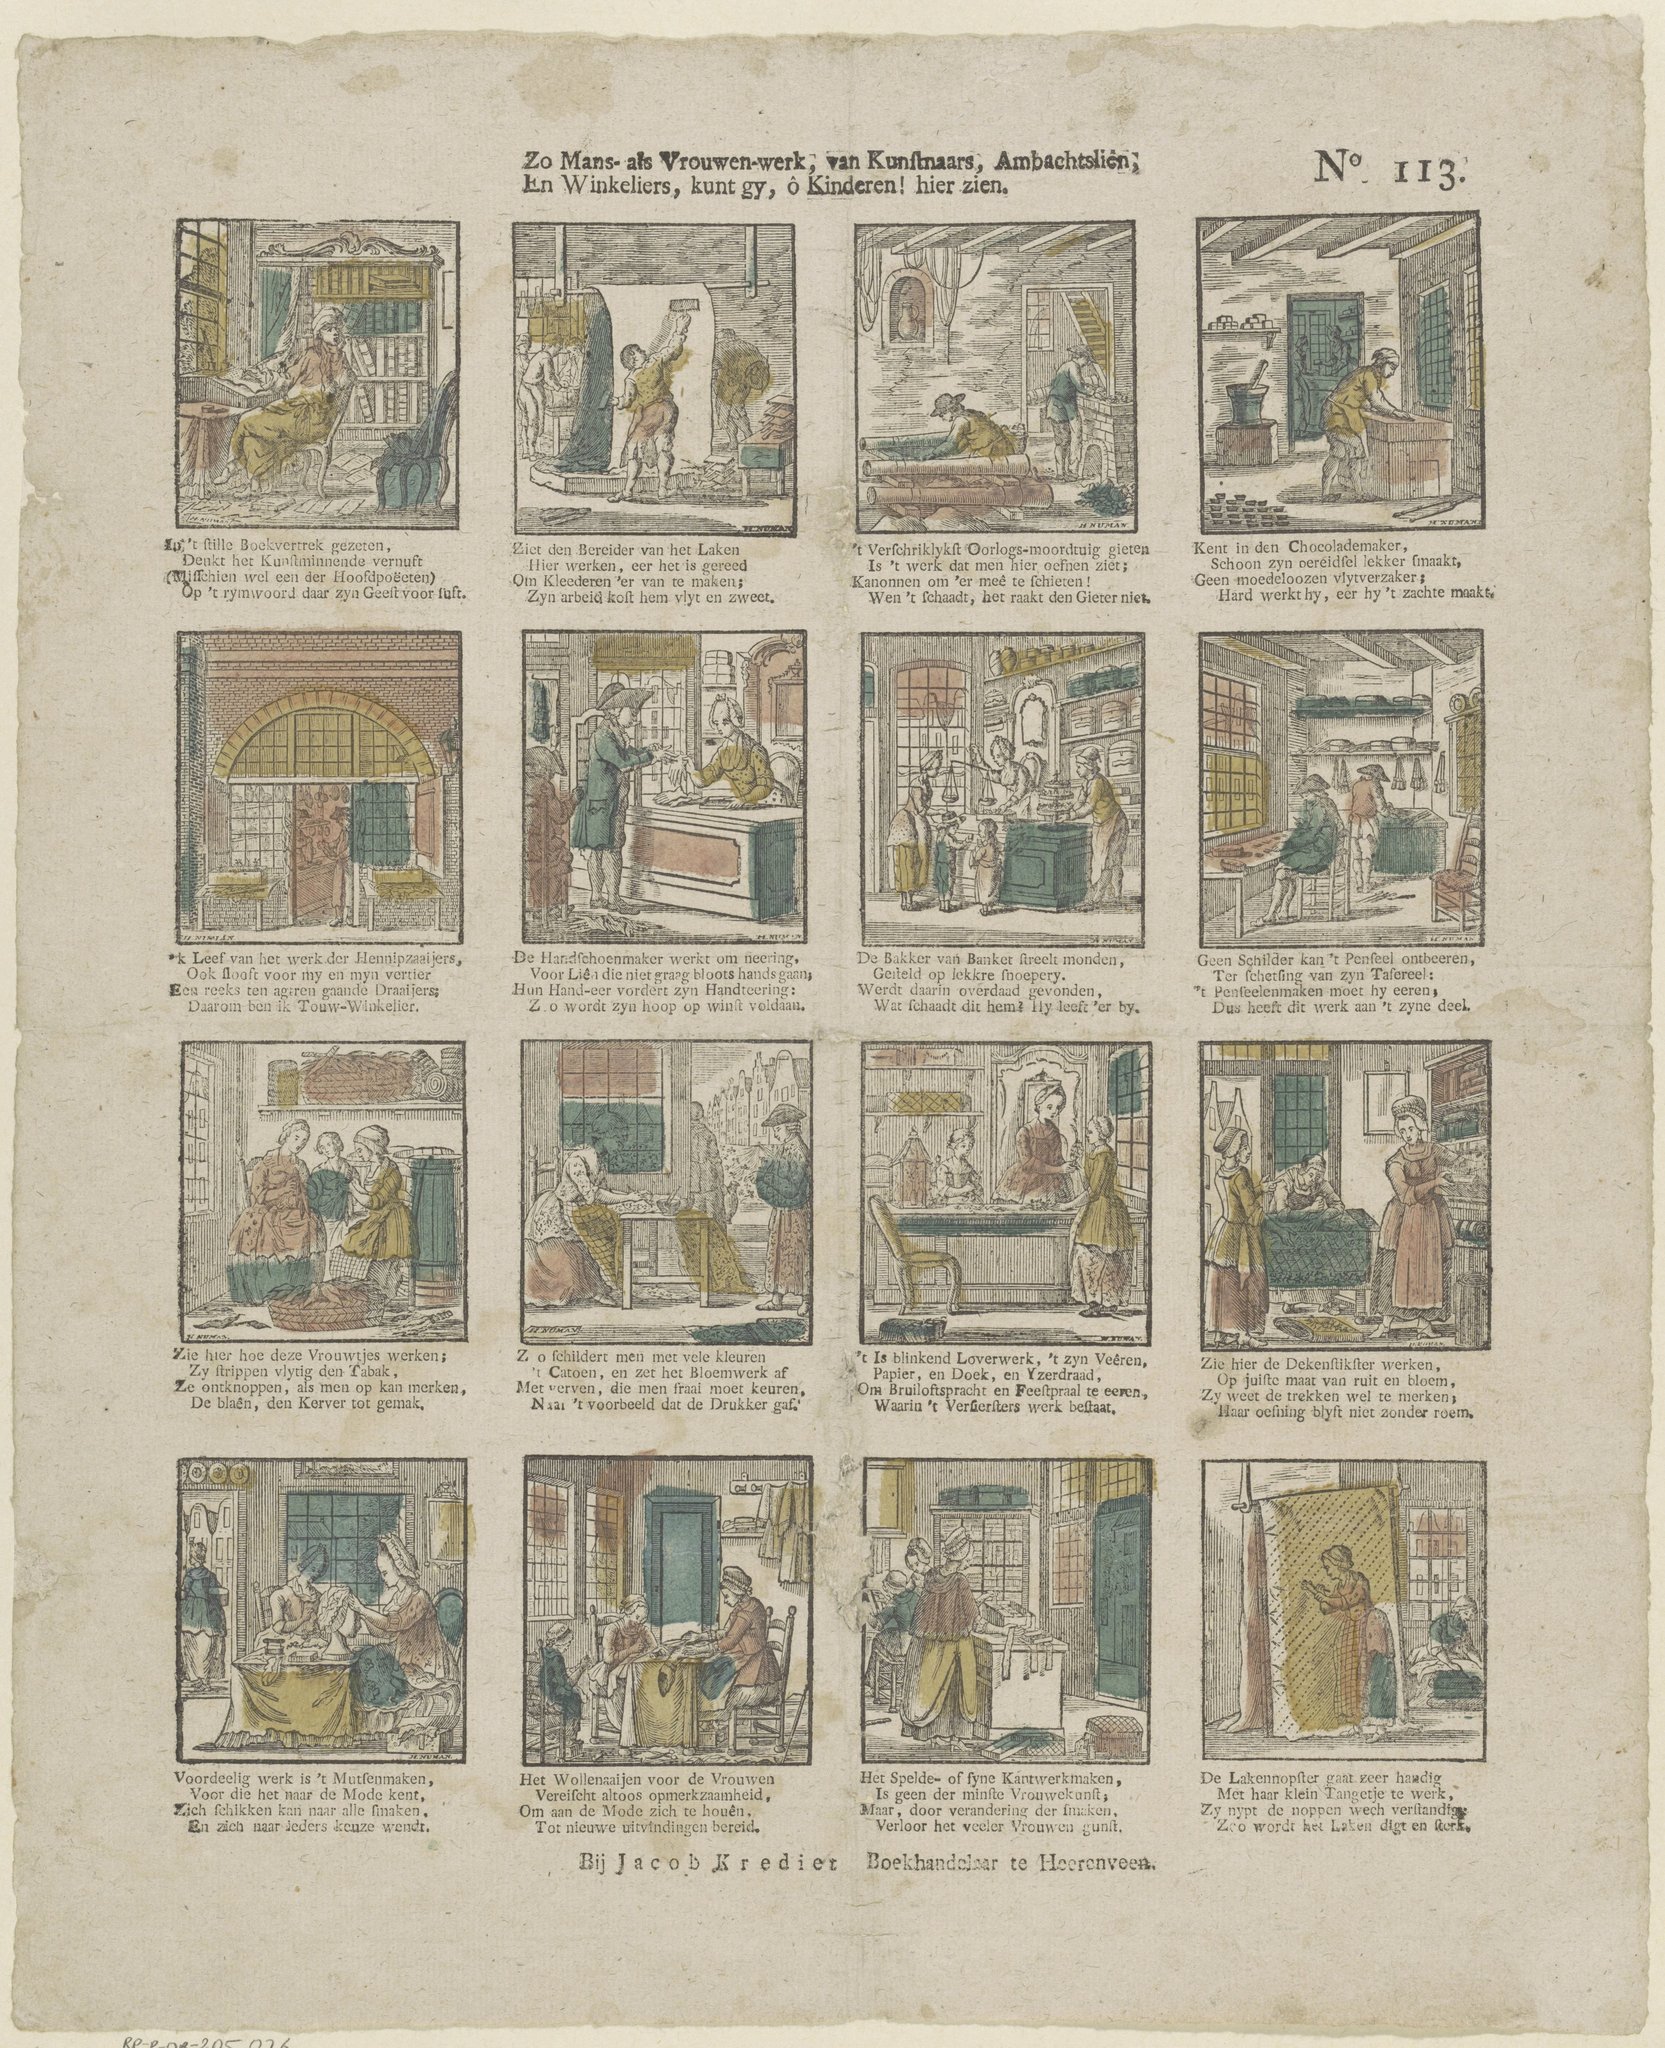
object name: print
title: Zo mans- als vrouwen-werk, van kunstenaars, ambachtsliên, / En winkeliers, kunt gy, ô kinderen! hier zien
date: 1806-1830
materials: paper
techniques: colour, letterpress printing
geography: zaltbommel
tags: craft-production, skilled handiwork, baker, crafts and industries, merchant, salesman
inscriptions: inscription, collector's mark: Lugt 2760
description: Blad met 16 voorstellingen van ambachtslieden en beroepen, zoals kanonnengieter, chocolademaker, winkelier en naaister. Onder elke afbeelding een vierregelig vers. Genummerd rechtsboven: No. 113.